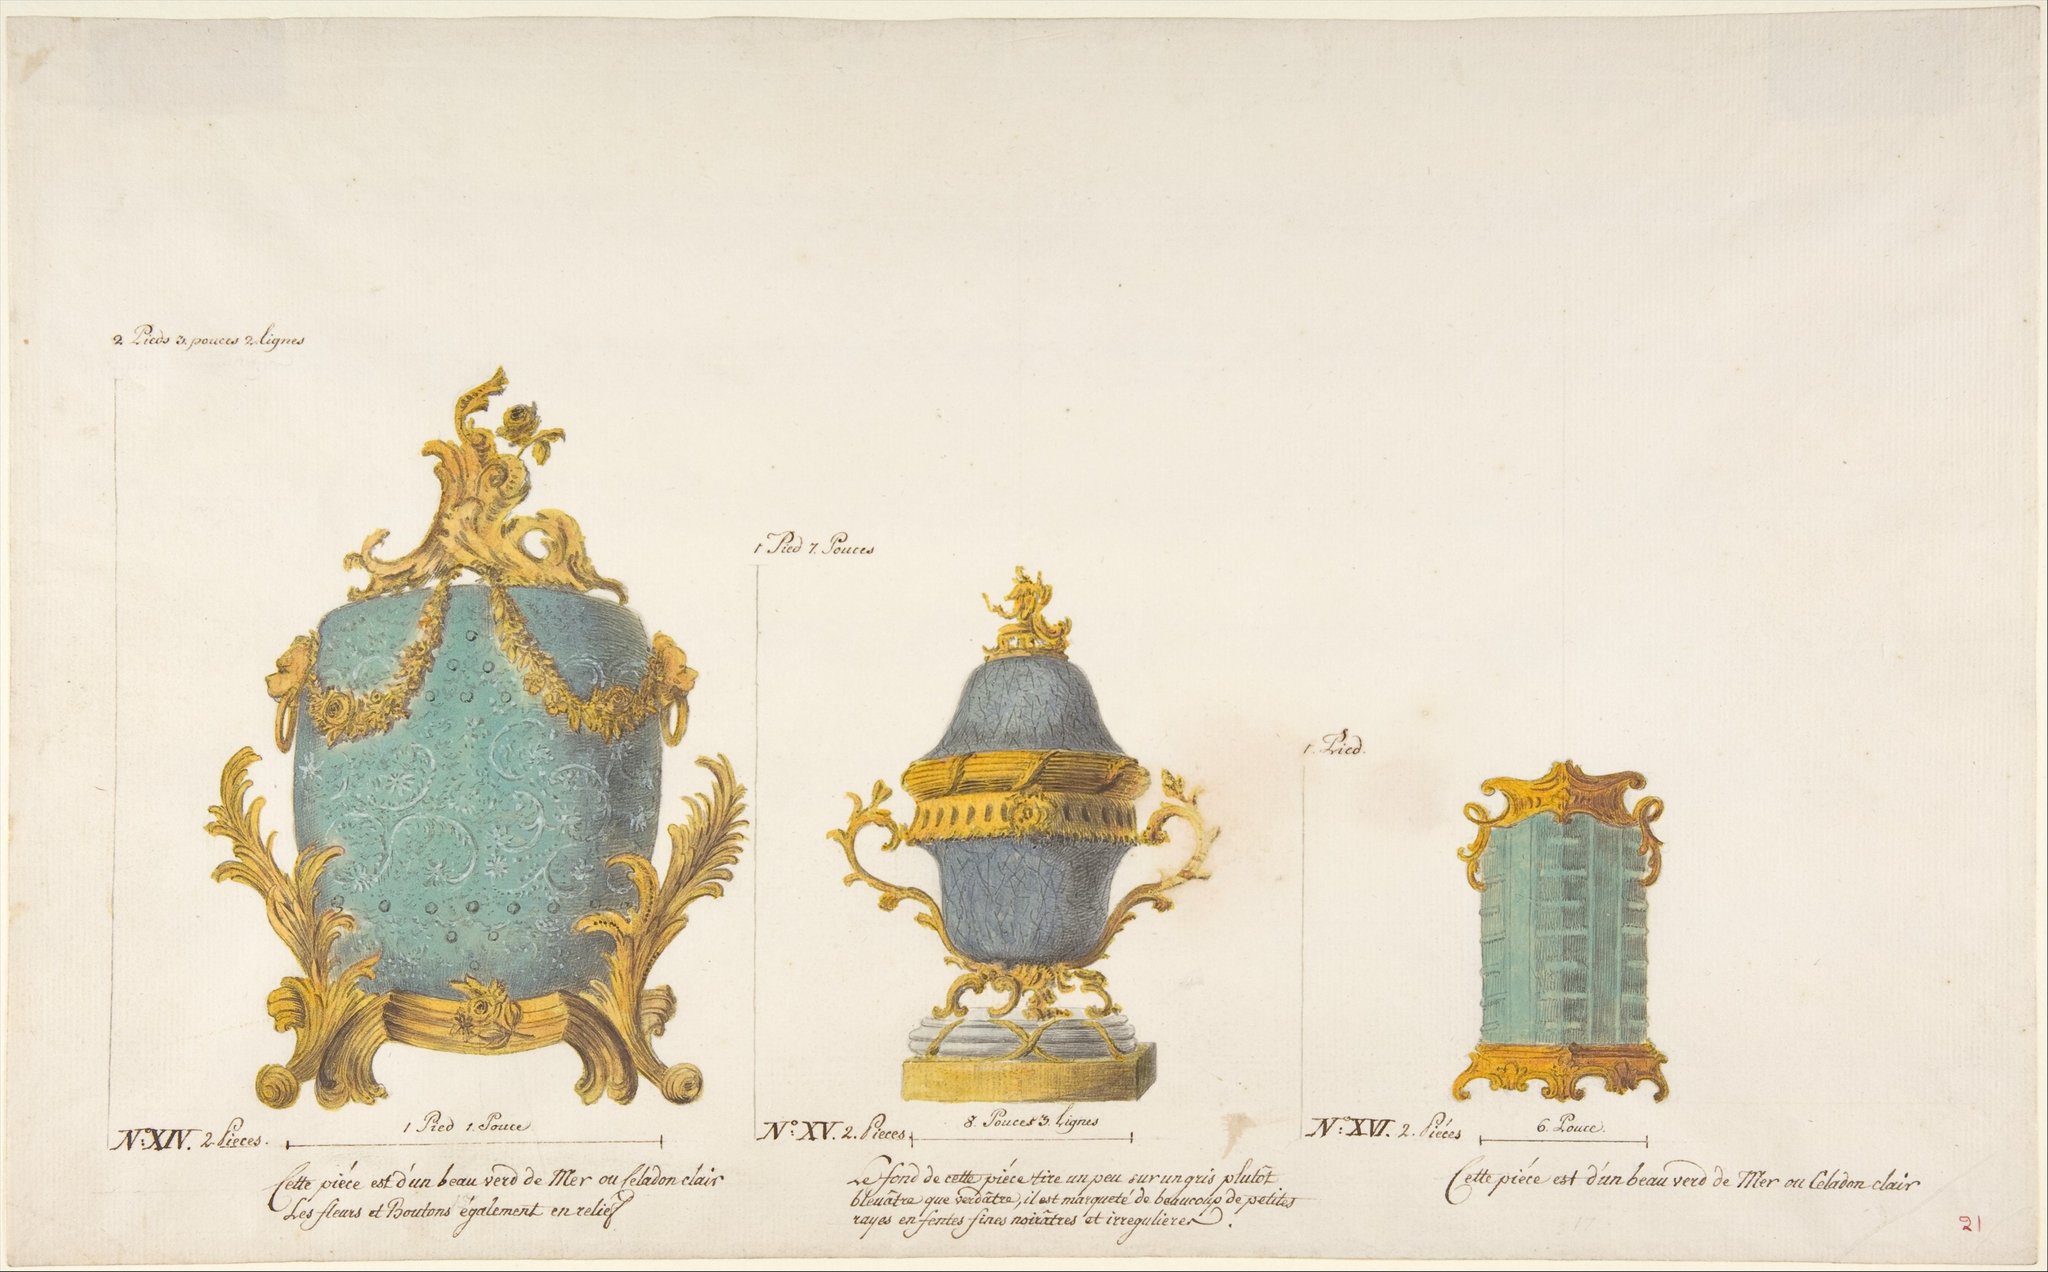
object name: drawing ornament architecture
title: Design for Three Vases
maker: anonymous, french, 18th century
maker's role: artist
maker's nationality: french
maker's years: 1700-1800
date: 1770-1785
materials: chalk, ink, watercolor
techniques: pen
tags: vases